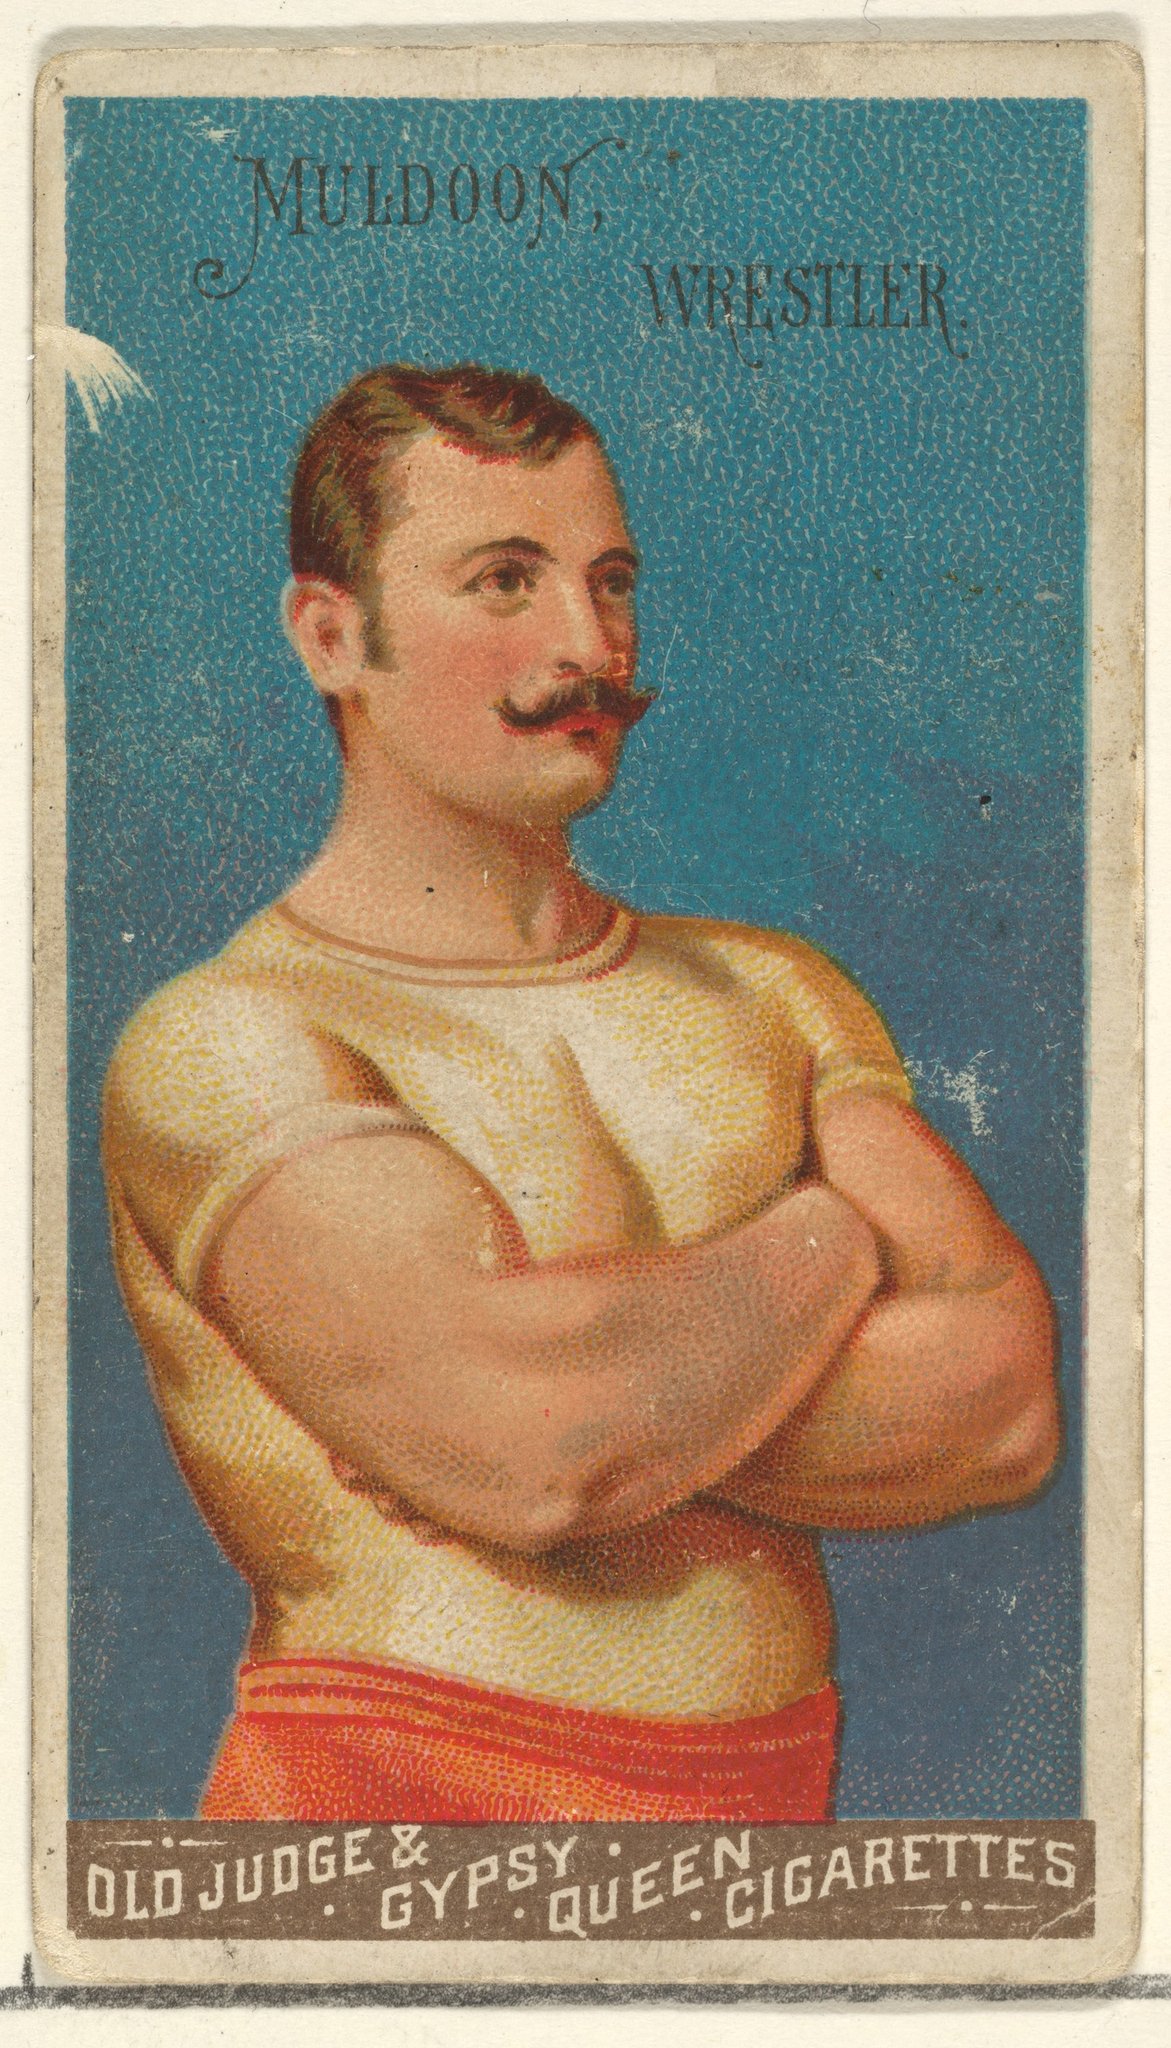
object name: print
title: Muldoon, Wrestler, from the Goodwin Champion series for Old Judge and Gypsy Queen Cigarettes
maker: goodwin & company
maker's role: publisher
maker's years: 1850-1950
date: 1888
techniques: color lithograph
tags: men,portraits,athletes